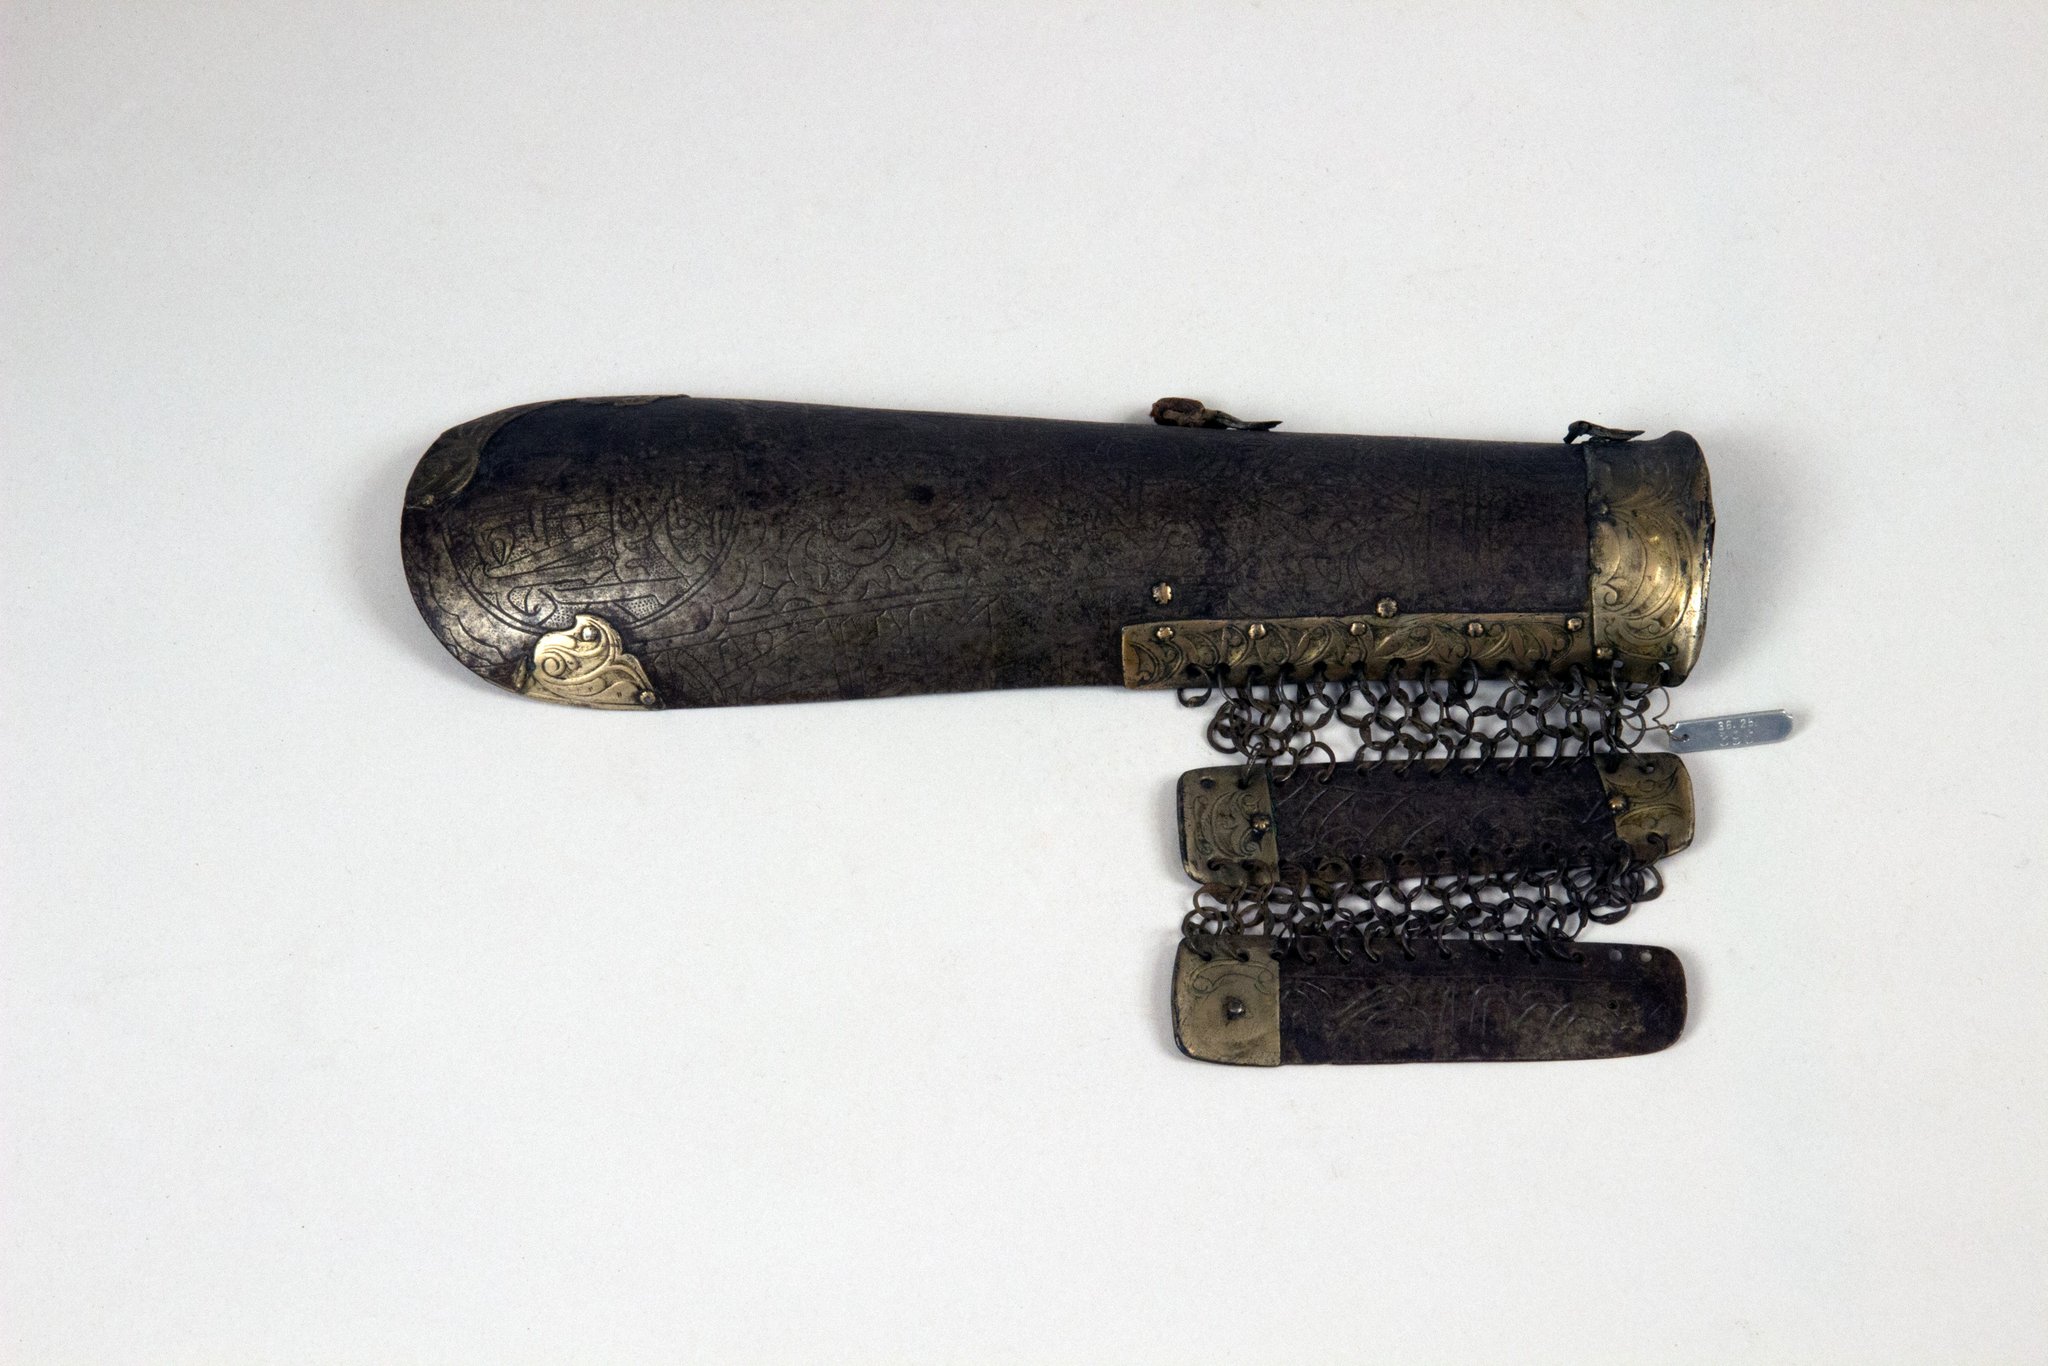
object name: left arm guard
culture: turkish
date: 1501-1700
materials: copper, steel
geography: ottoman empire